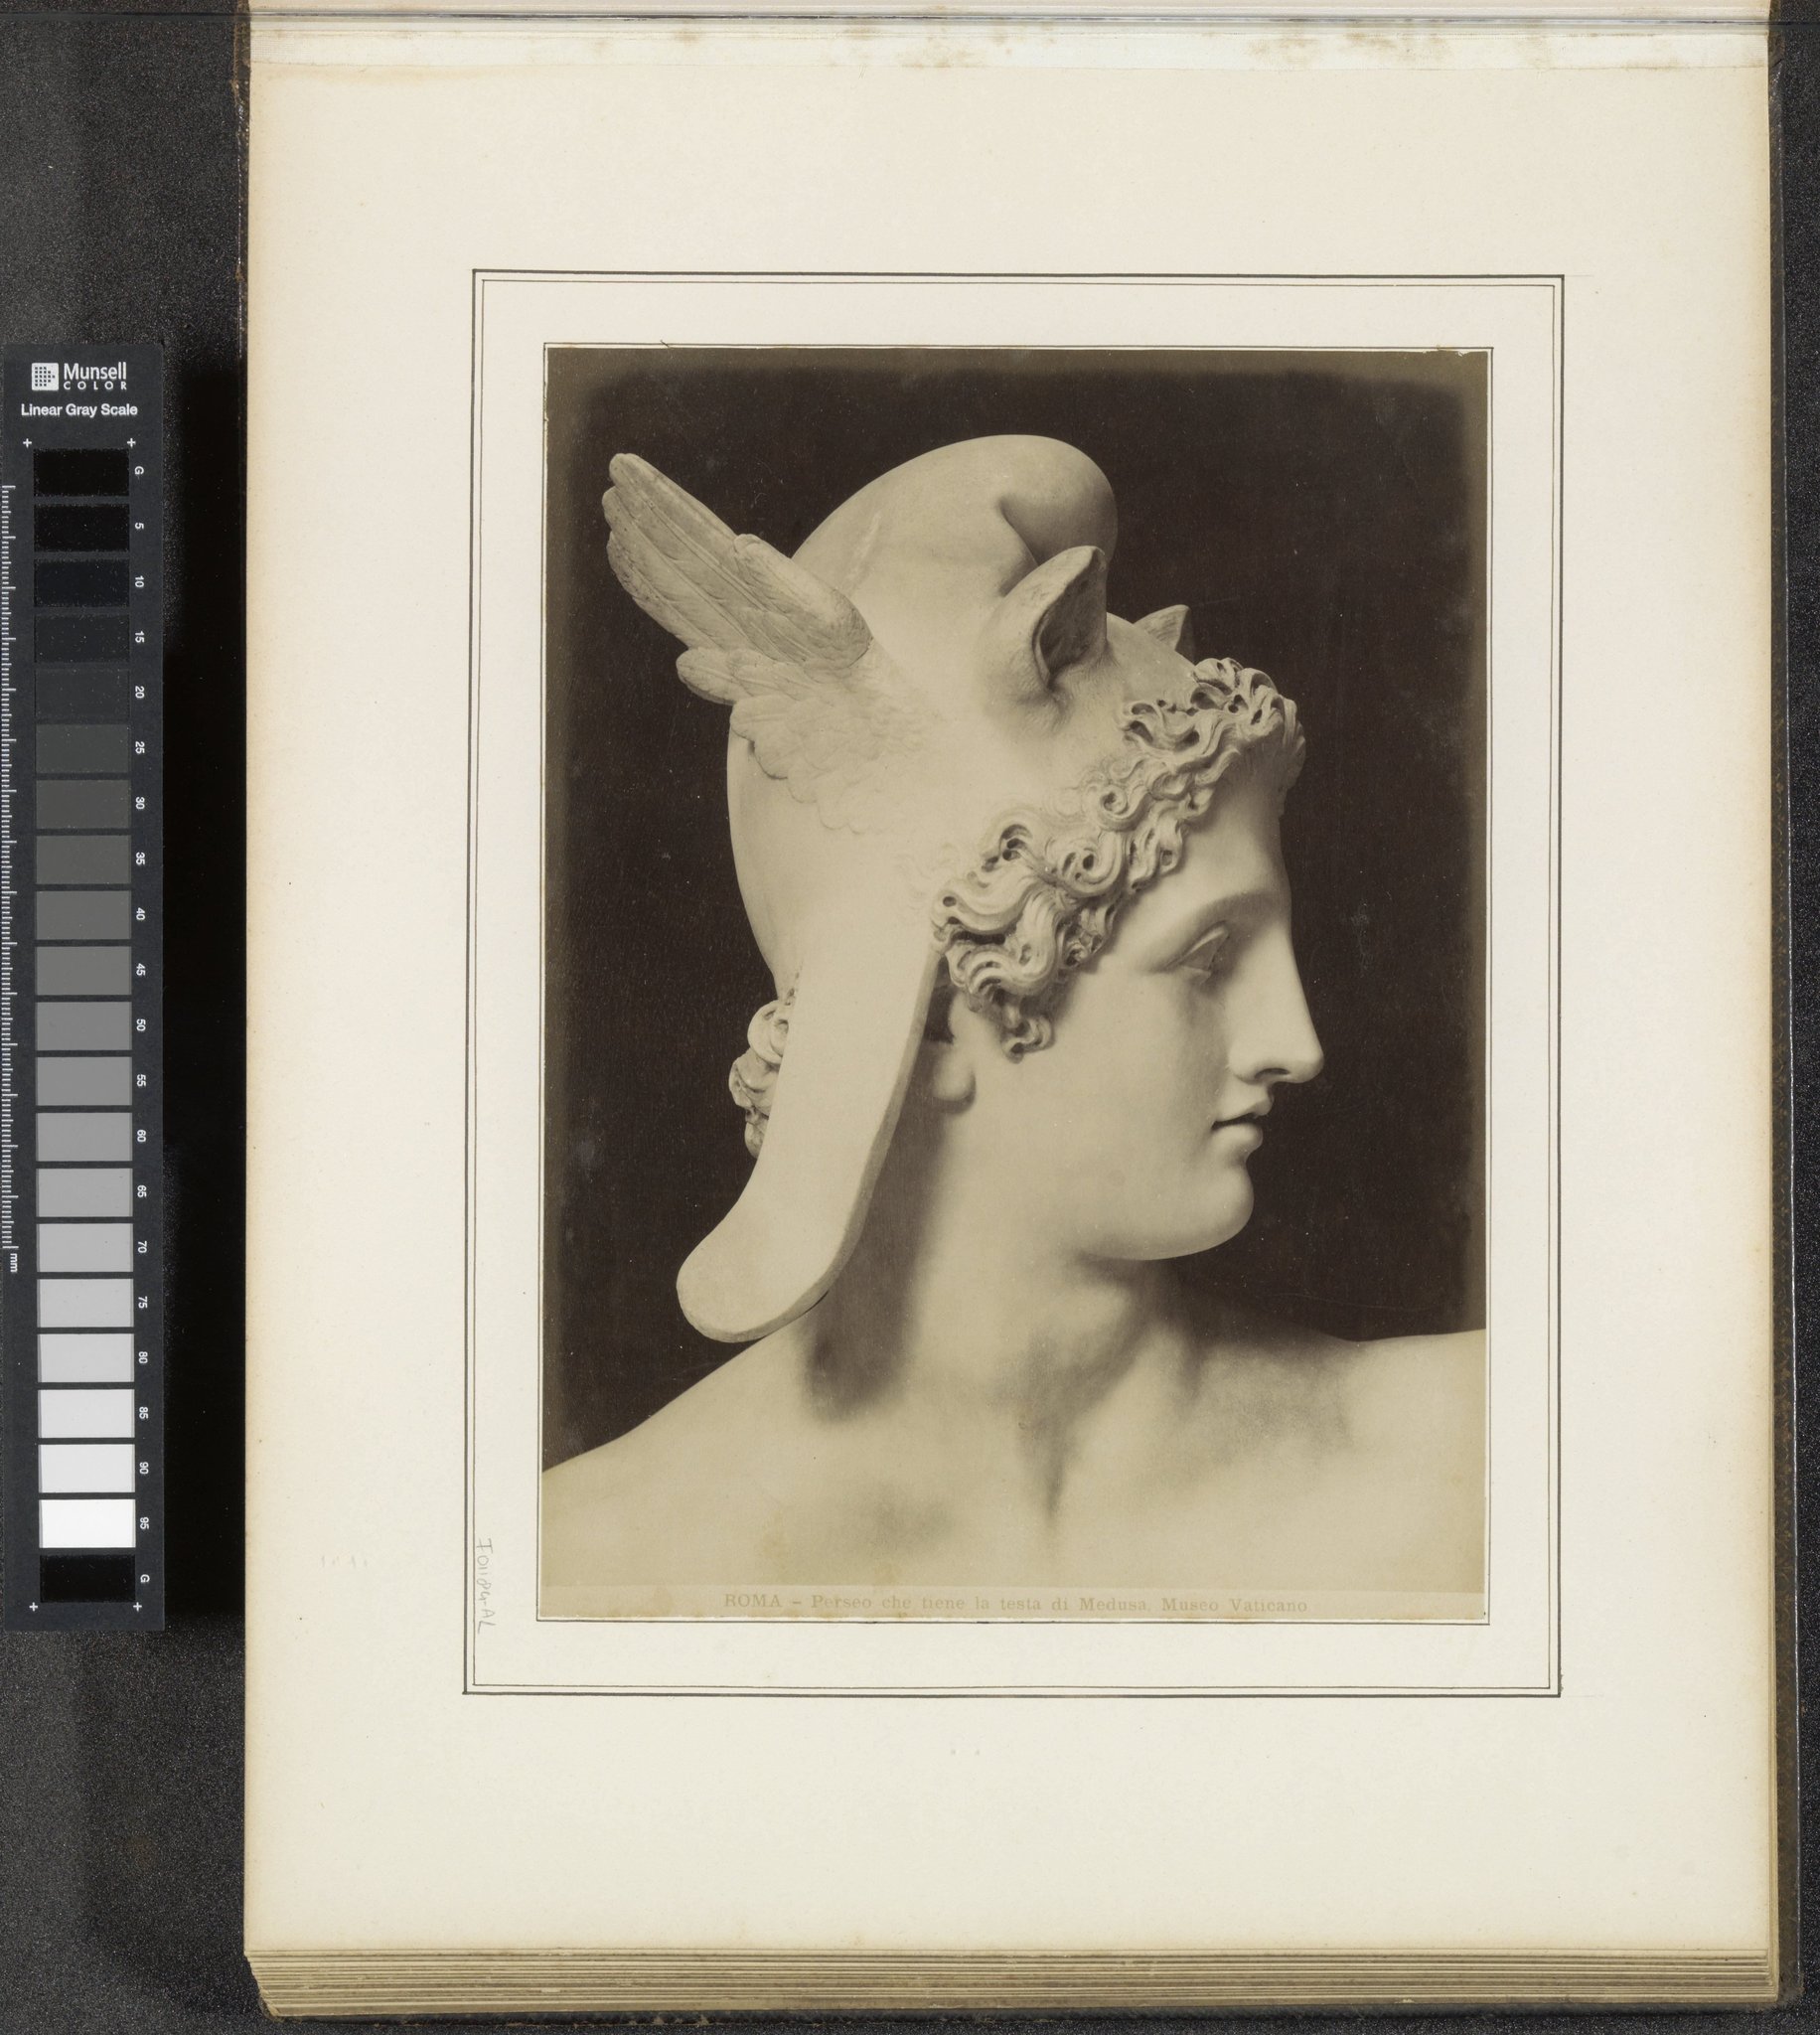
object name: photograph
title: ROMA - Perseo che tiene la testa di Medusa Museo Vaticano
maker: Anonymous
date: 1865-1890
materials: paper, photographic support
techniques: albumen print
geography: rome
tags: piece of sculpture, reproduction of a piece of sculpture, rome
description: Onderdeel van Reisalbum met foto's van bezienswaardigheden in Italië (deel I).